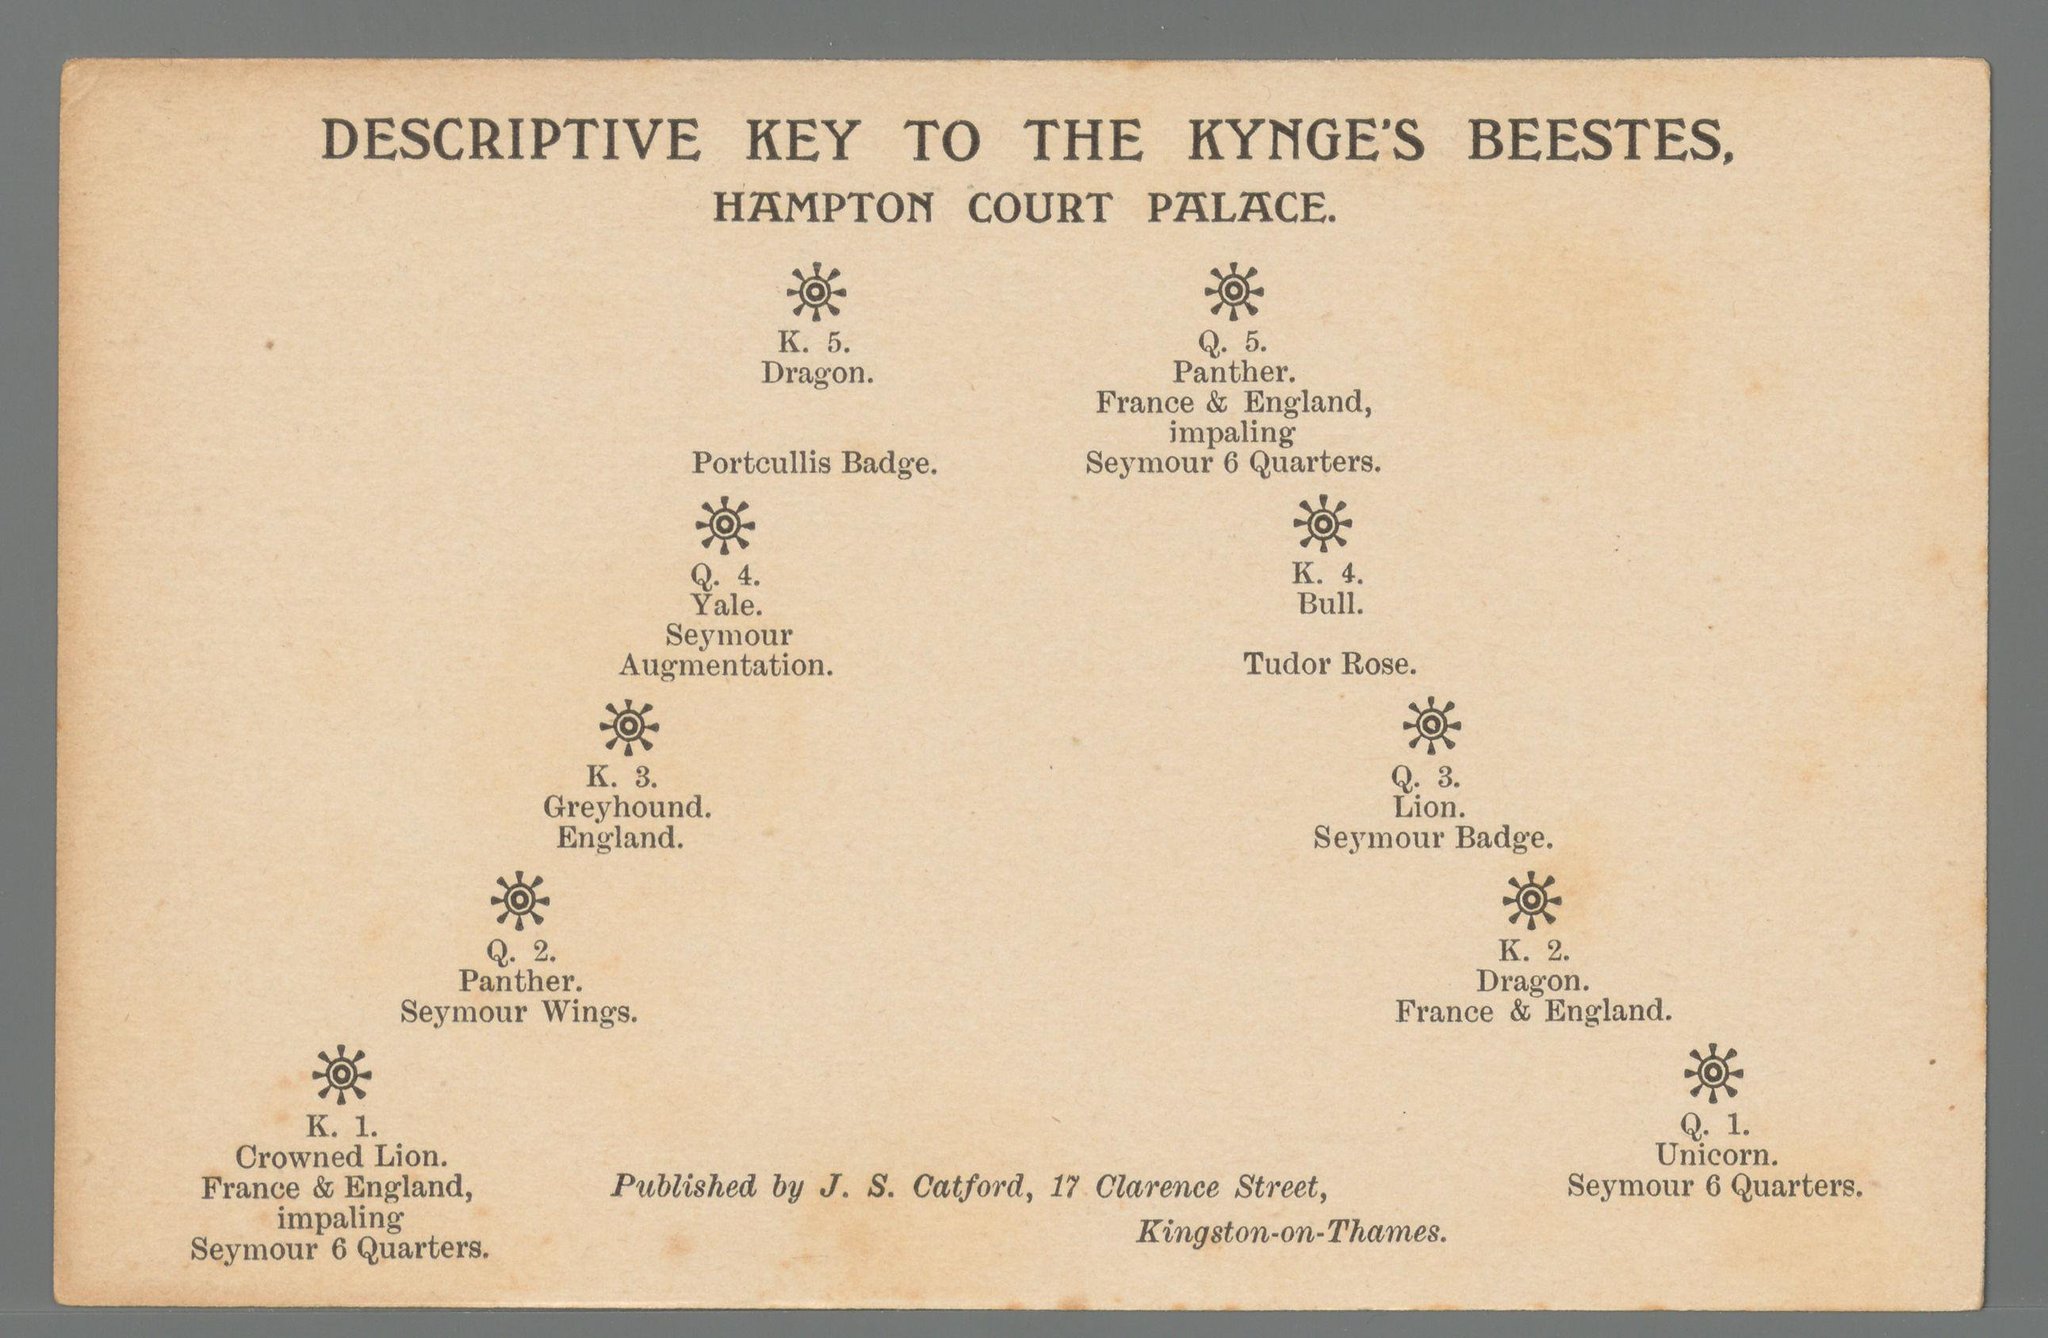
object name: ansichtkaart, prentbriefkaart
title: Descriptive key to the Kynge's Beestes. Hampton Court Palace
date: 1894-1905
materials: cardboard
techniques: printing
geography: kingston-upon-thames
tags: palace